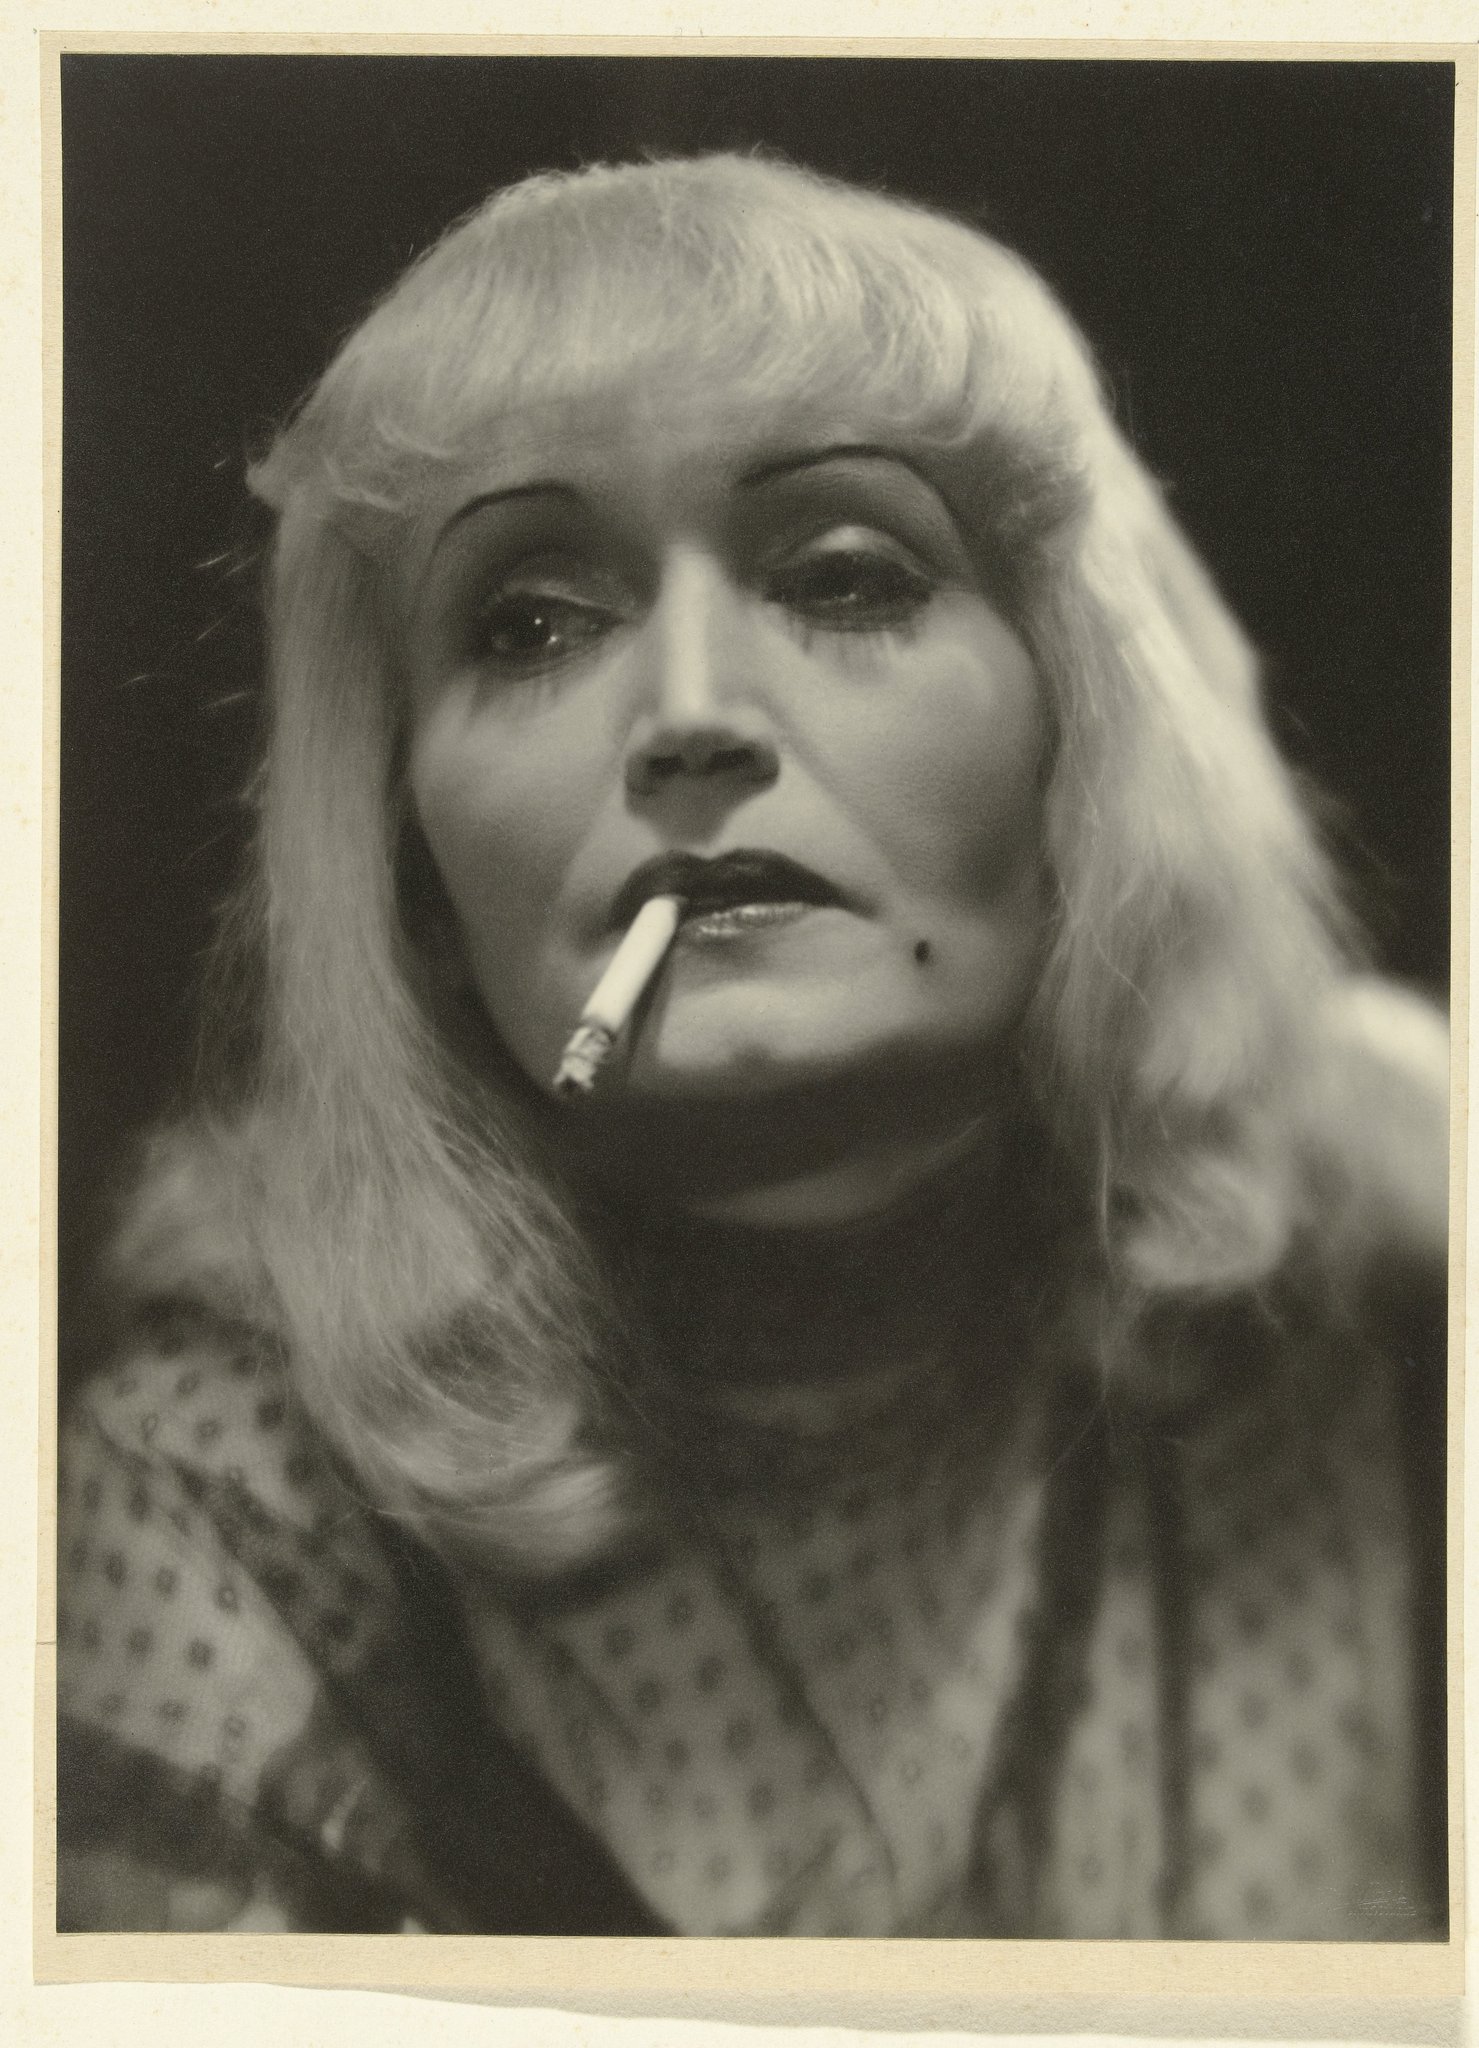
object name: photograph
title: Portret actrice Nel Knoop in geruite mantel, gegrimeerd en met sigaret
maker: jacob merkelbach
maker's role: fotograaf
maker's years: 1877-1942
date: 1930-1945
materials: cardboard, photographic support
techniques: gelatin silver print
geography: amsterdam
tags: portrait of actor, actress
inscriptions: inscription: ‘Nel Knoop’